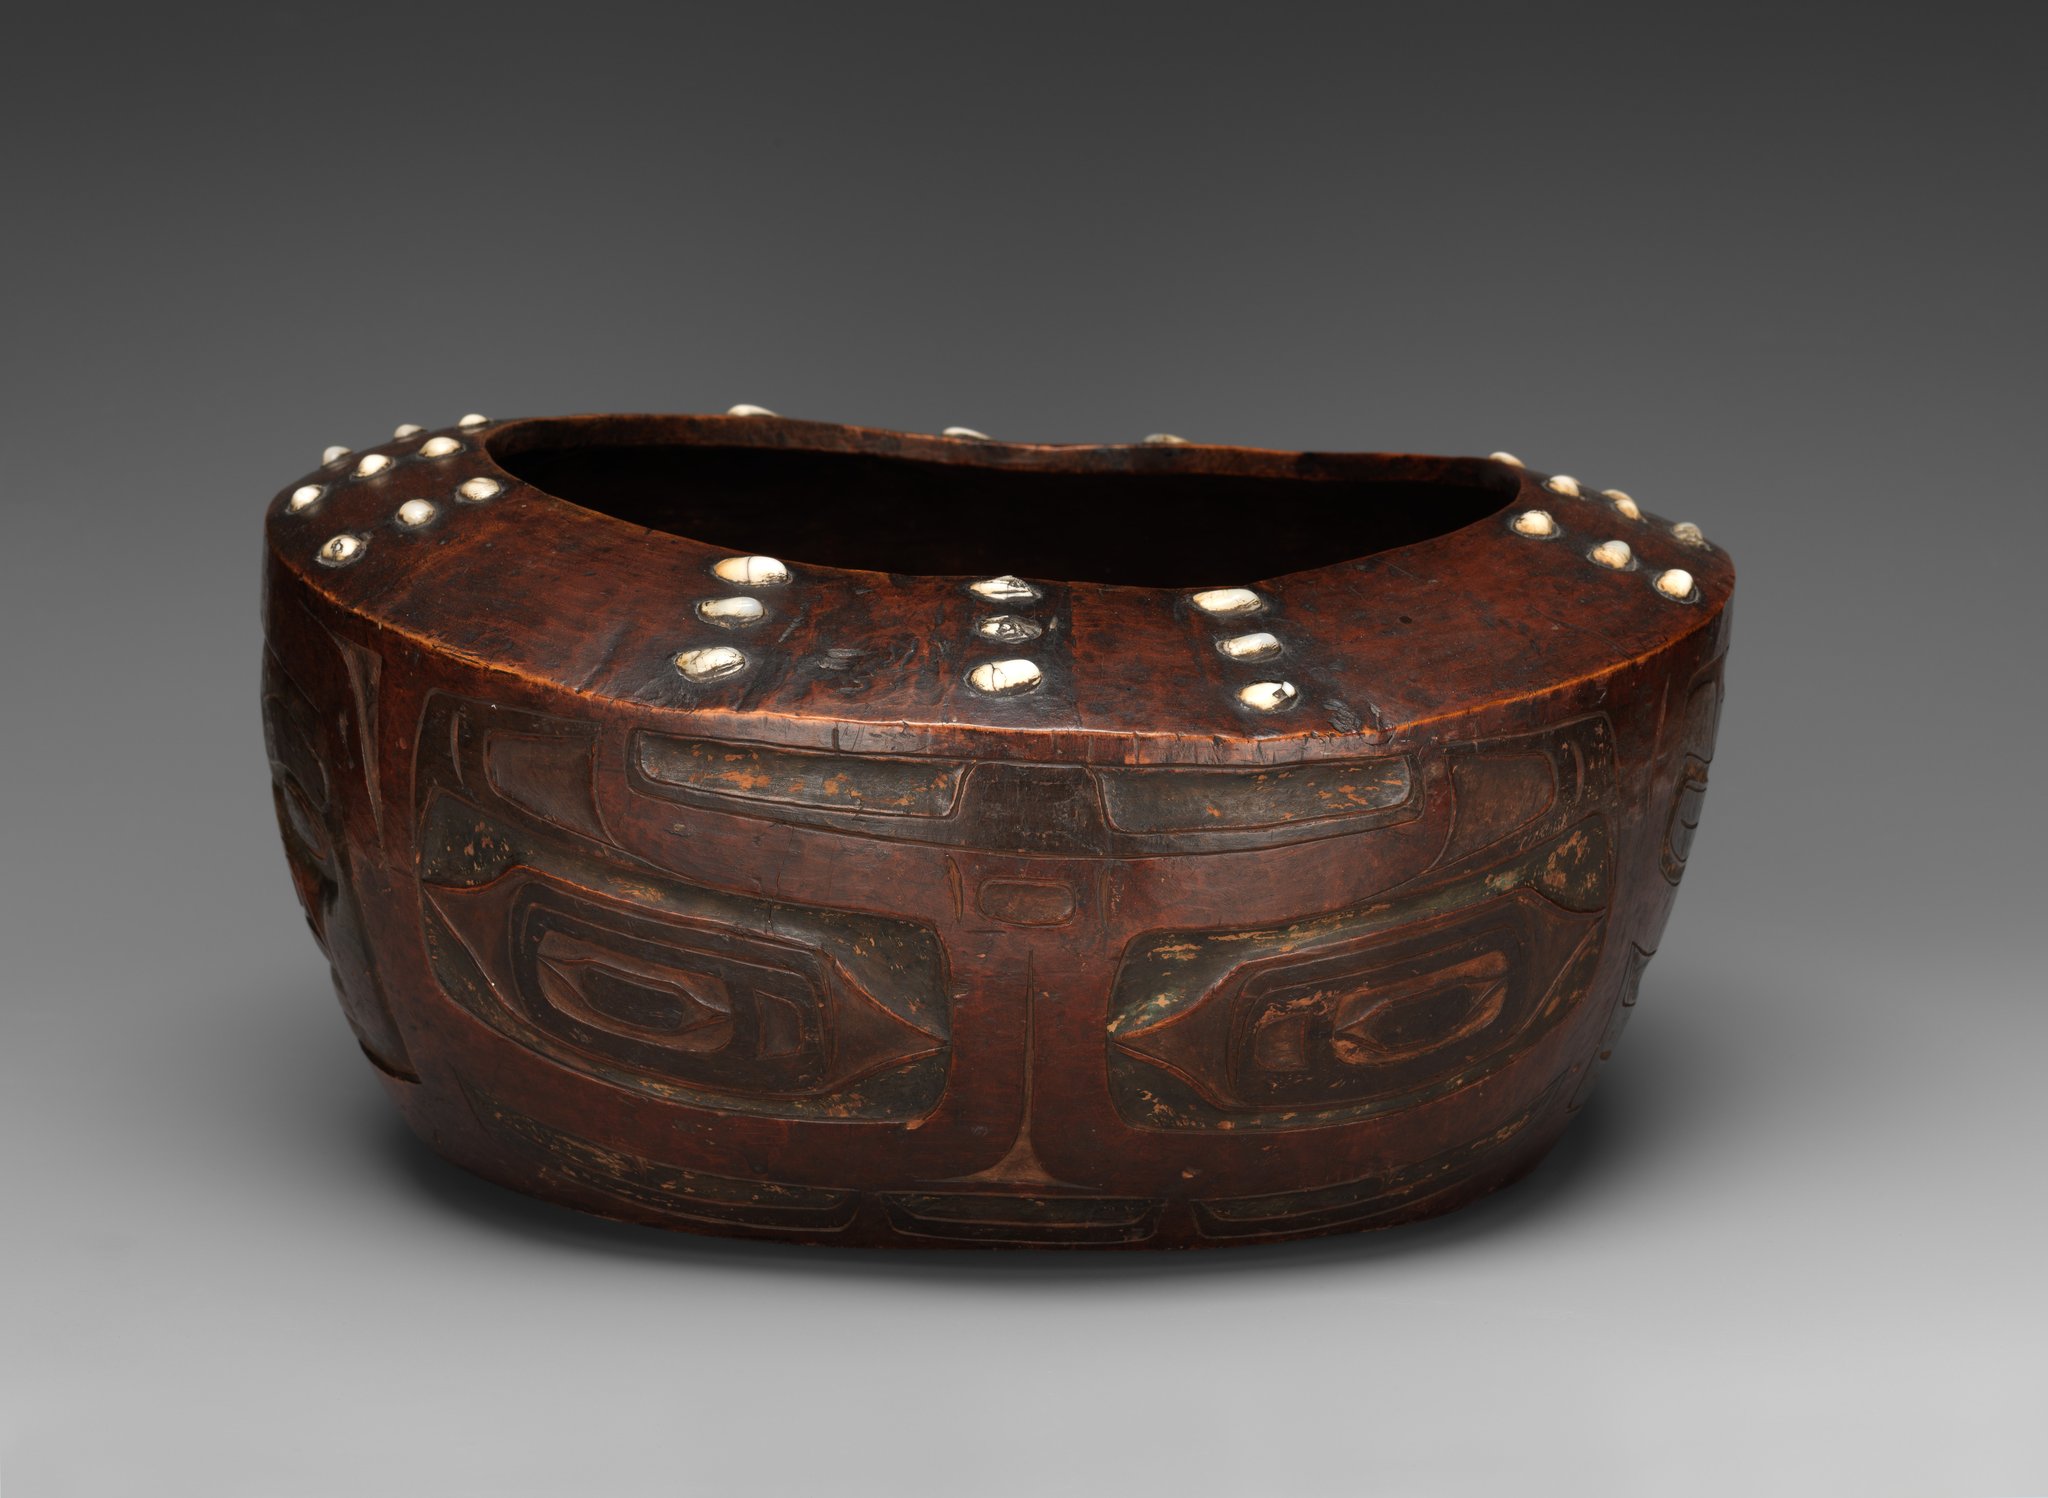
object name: bowl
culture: tlingit or native american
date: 1750-1800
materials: pigment, shell, wood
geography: united states